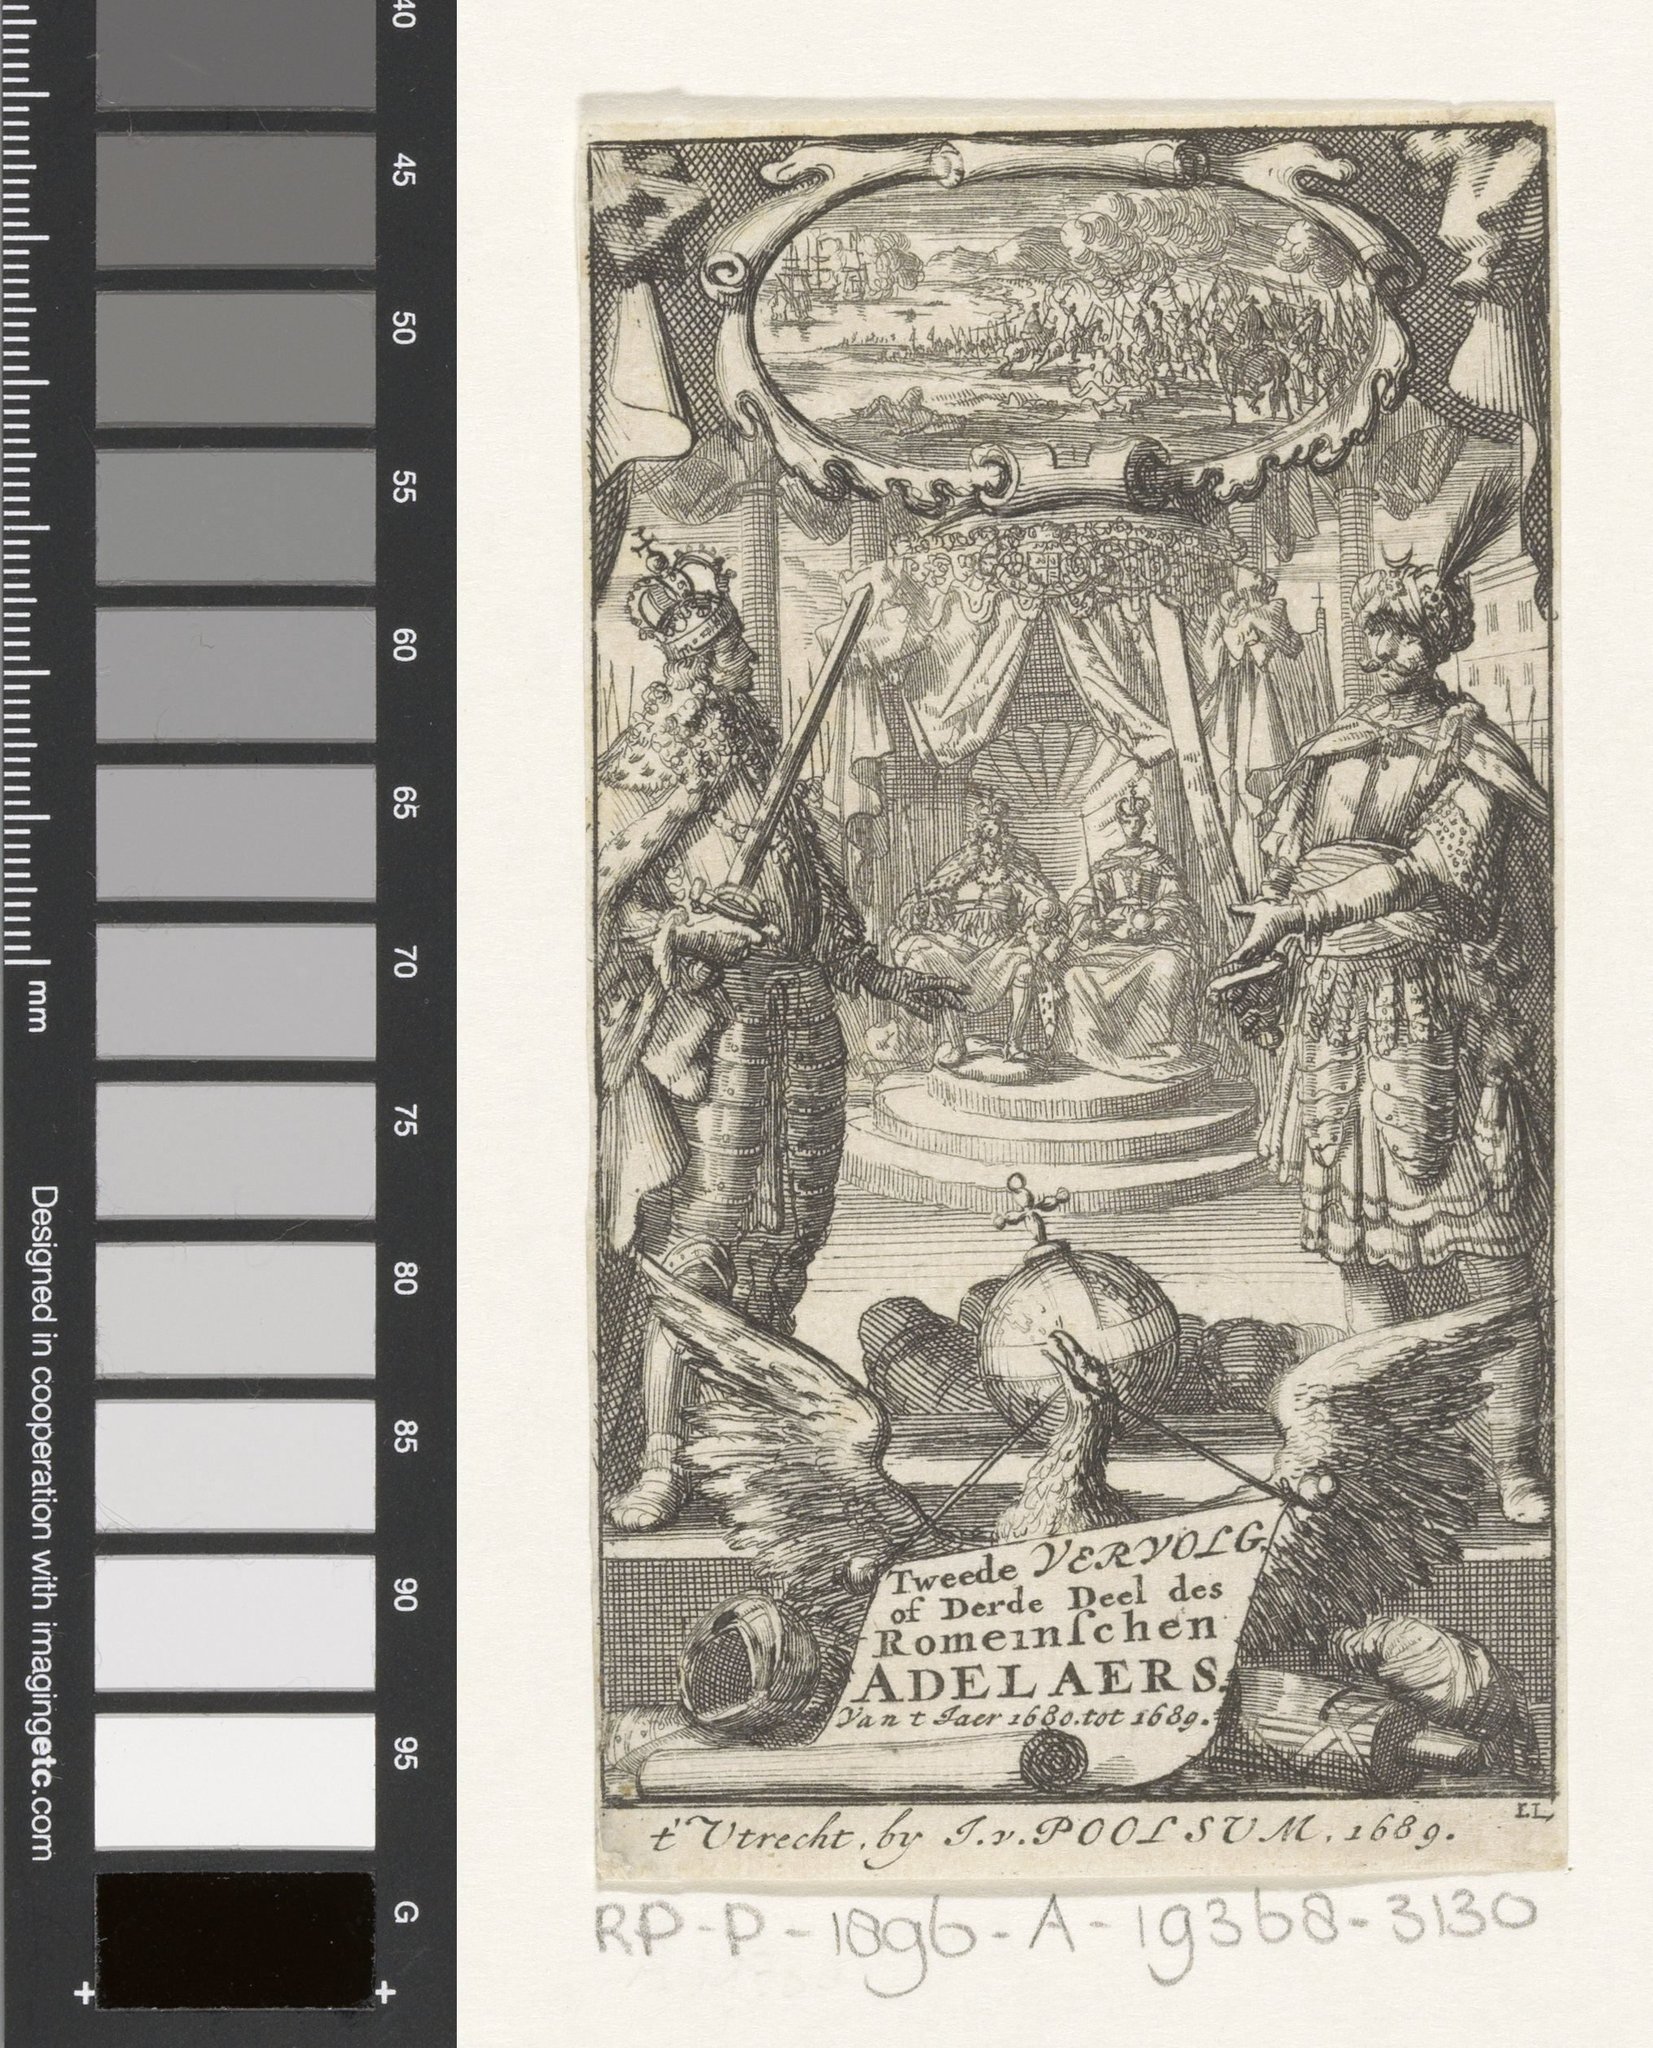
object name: print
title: Koning, Turkse bevelhebber en Willem III en Maria Stuart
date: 1689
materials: paper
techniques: etching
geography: amsterdam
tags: william iii (prince of orange and king of england, scotland, and ireland), london, maria ii stuart (koningin van engeland, schotland en ierland), head-gear: turban, king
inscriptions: collector's mark: Lugt 2228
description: Titelpagina voor: Pers, Dirck Pietersz. Romeynschen adelaer, waer in de loffelĳcke en lasterlĳcke daden der Romeynsche koningen, en keyseren, verhandelt werden, 3 delen. Dl. III. Utrecht: Poolsum, Jurriaen van, 1689.